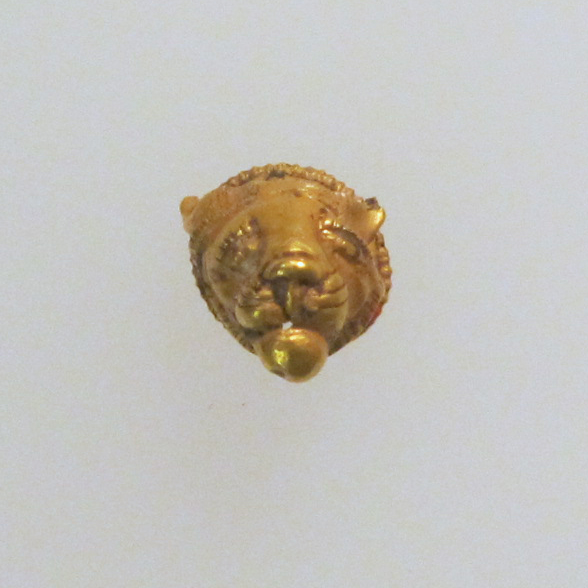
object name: pendant in the form of a lion's head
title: Pendant with lion's head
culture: etruscan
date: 700-401 BCE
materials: gold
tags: lions